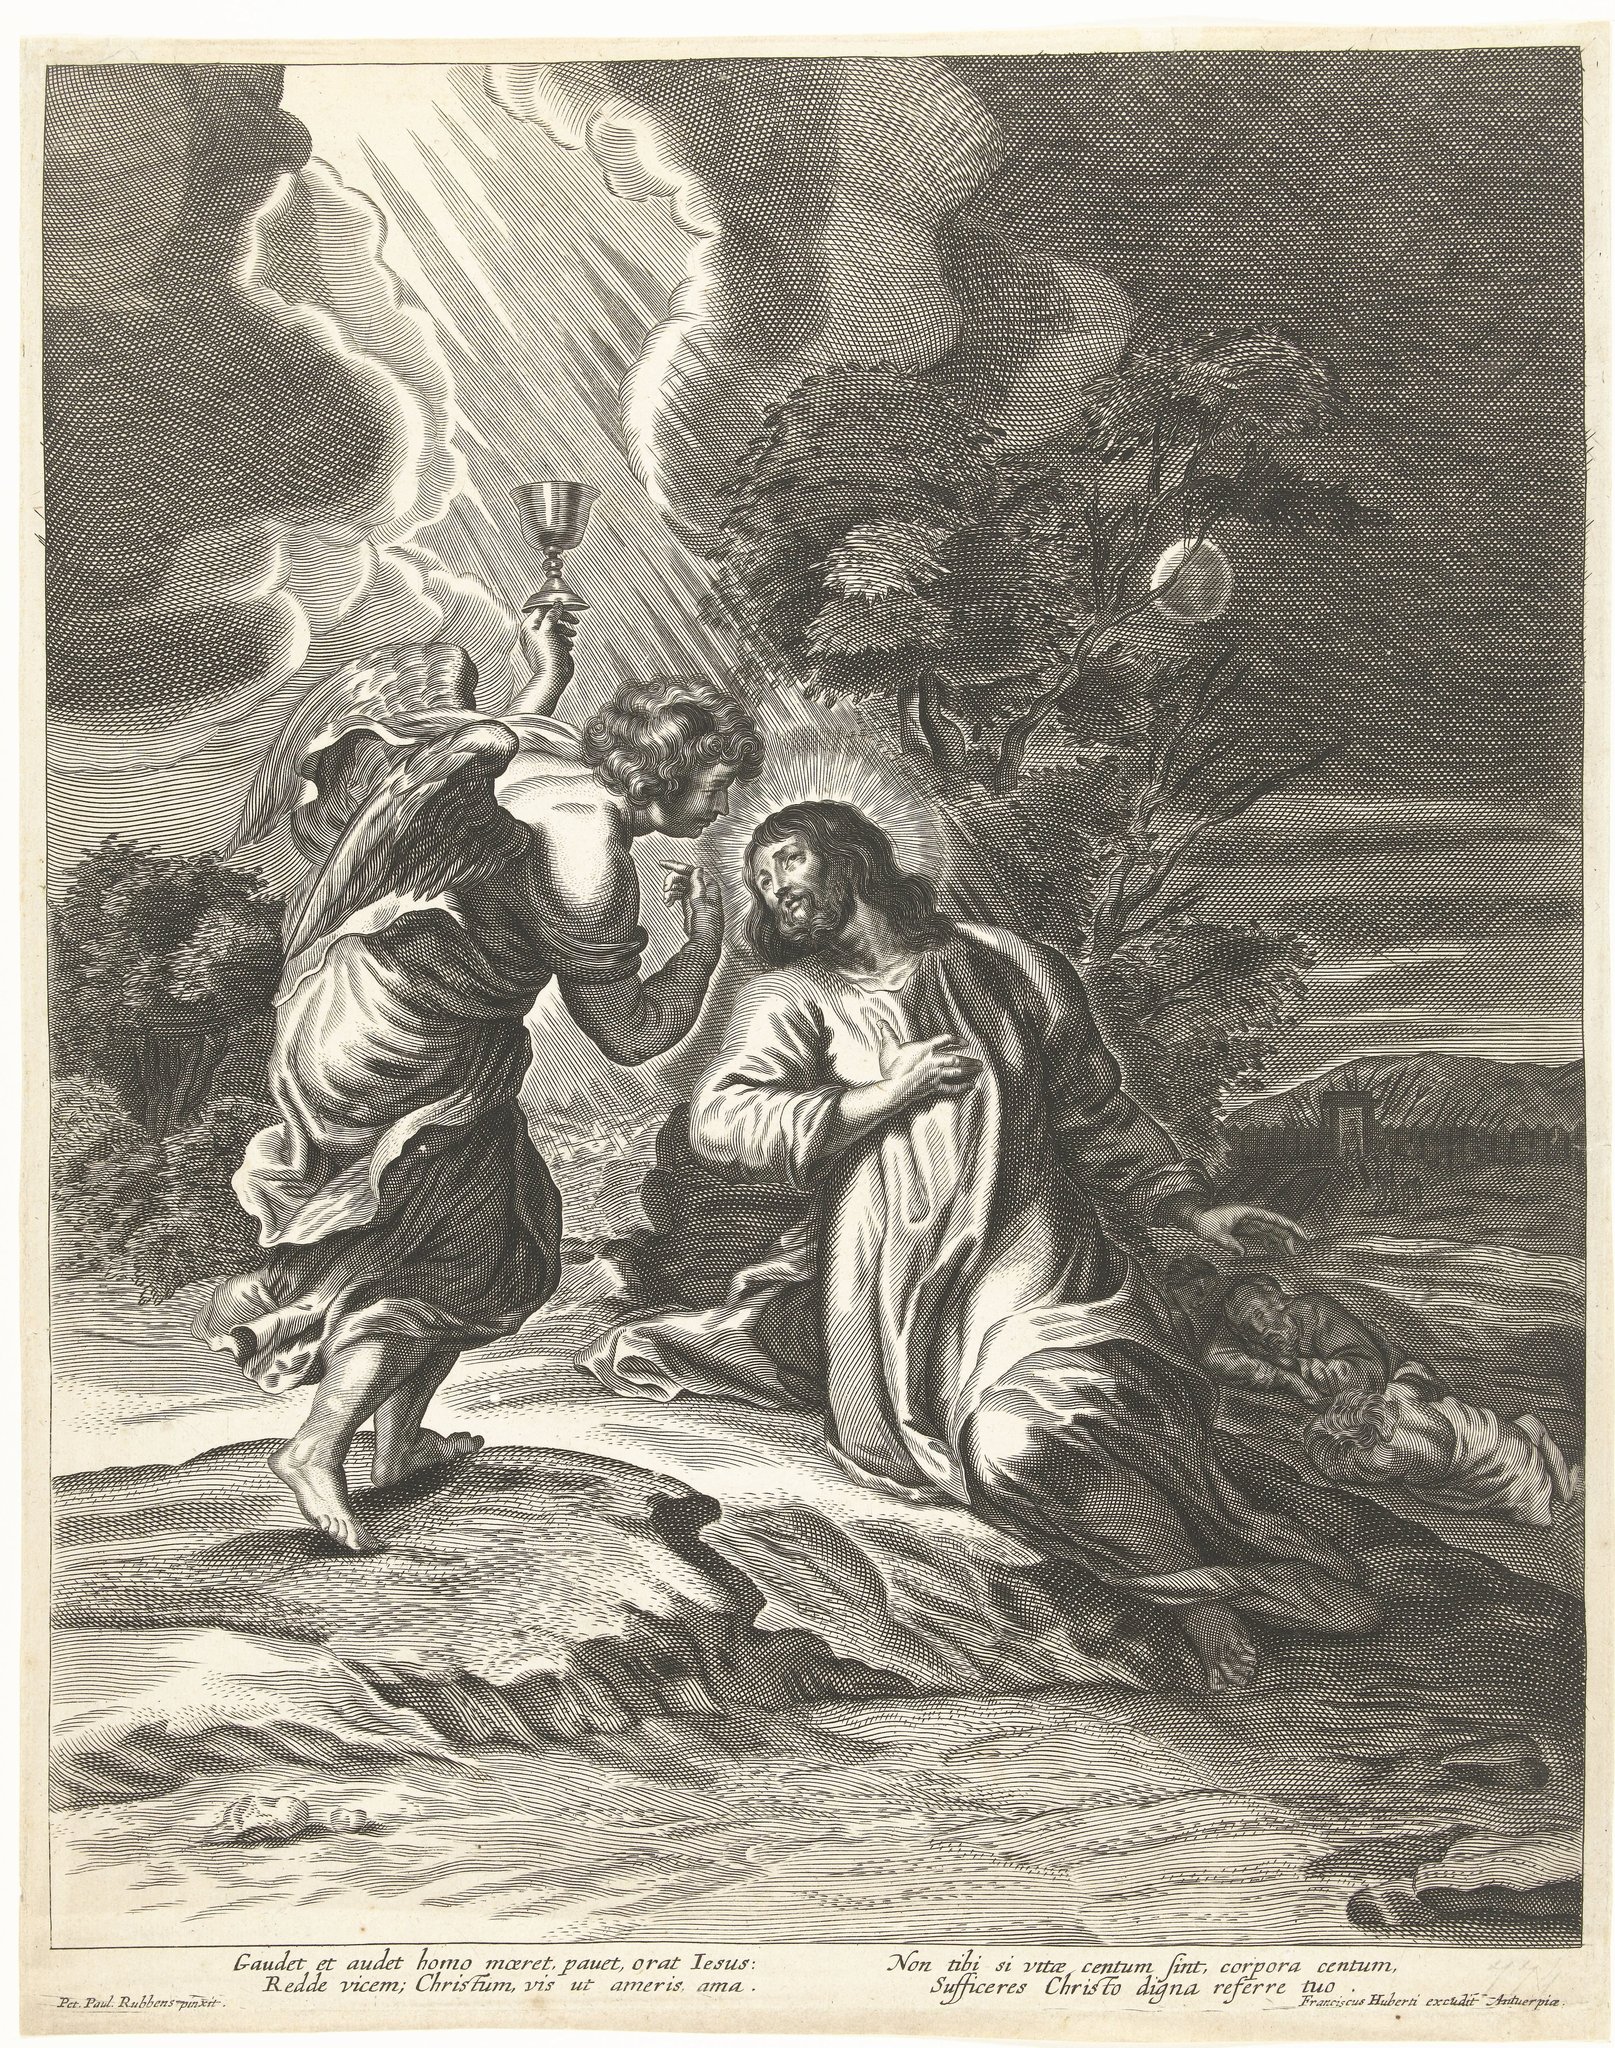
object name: print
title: Christus en engel met kelk op Olijfberg (Getsemane)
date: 1623-1710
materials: paper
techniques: engraving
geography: antwerp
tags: agony of christ: to comfort him one or more angels appear to christ with chalice and/or cross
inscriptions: collector's mark: Lugt 2228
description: Christus en engel met kelk op Olijfberg (Getsemane). Onder de voorstelling staan vier Latijnse versregels waarin wordt verwezen naar het lijden van Christus voor de gelovige.